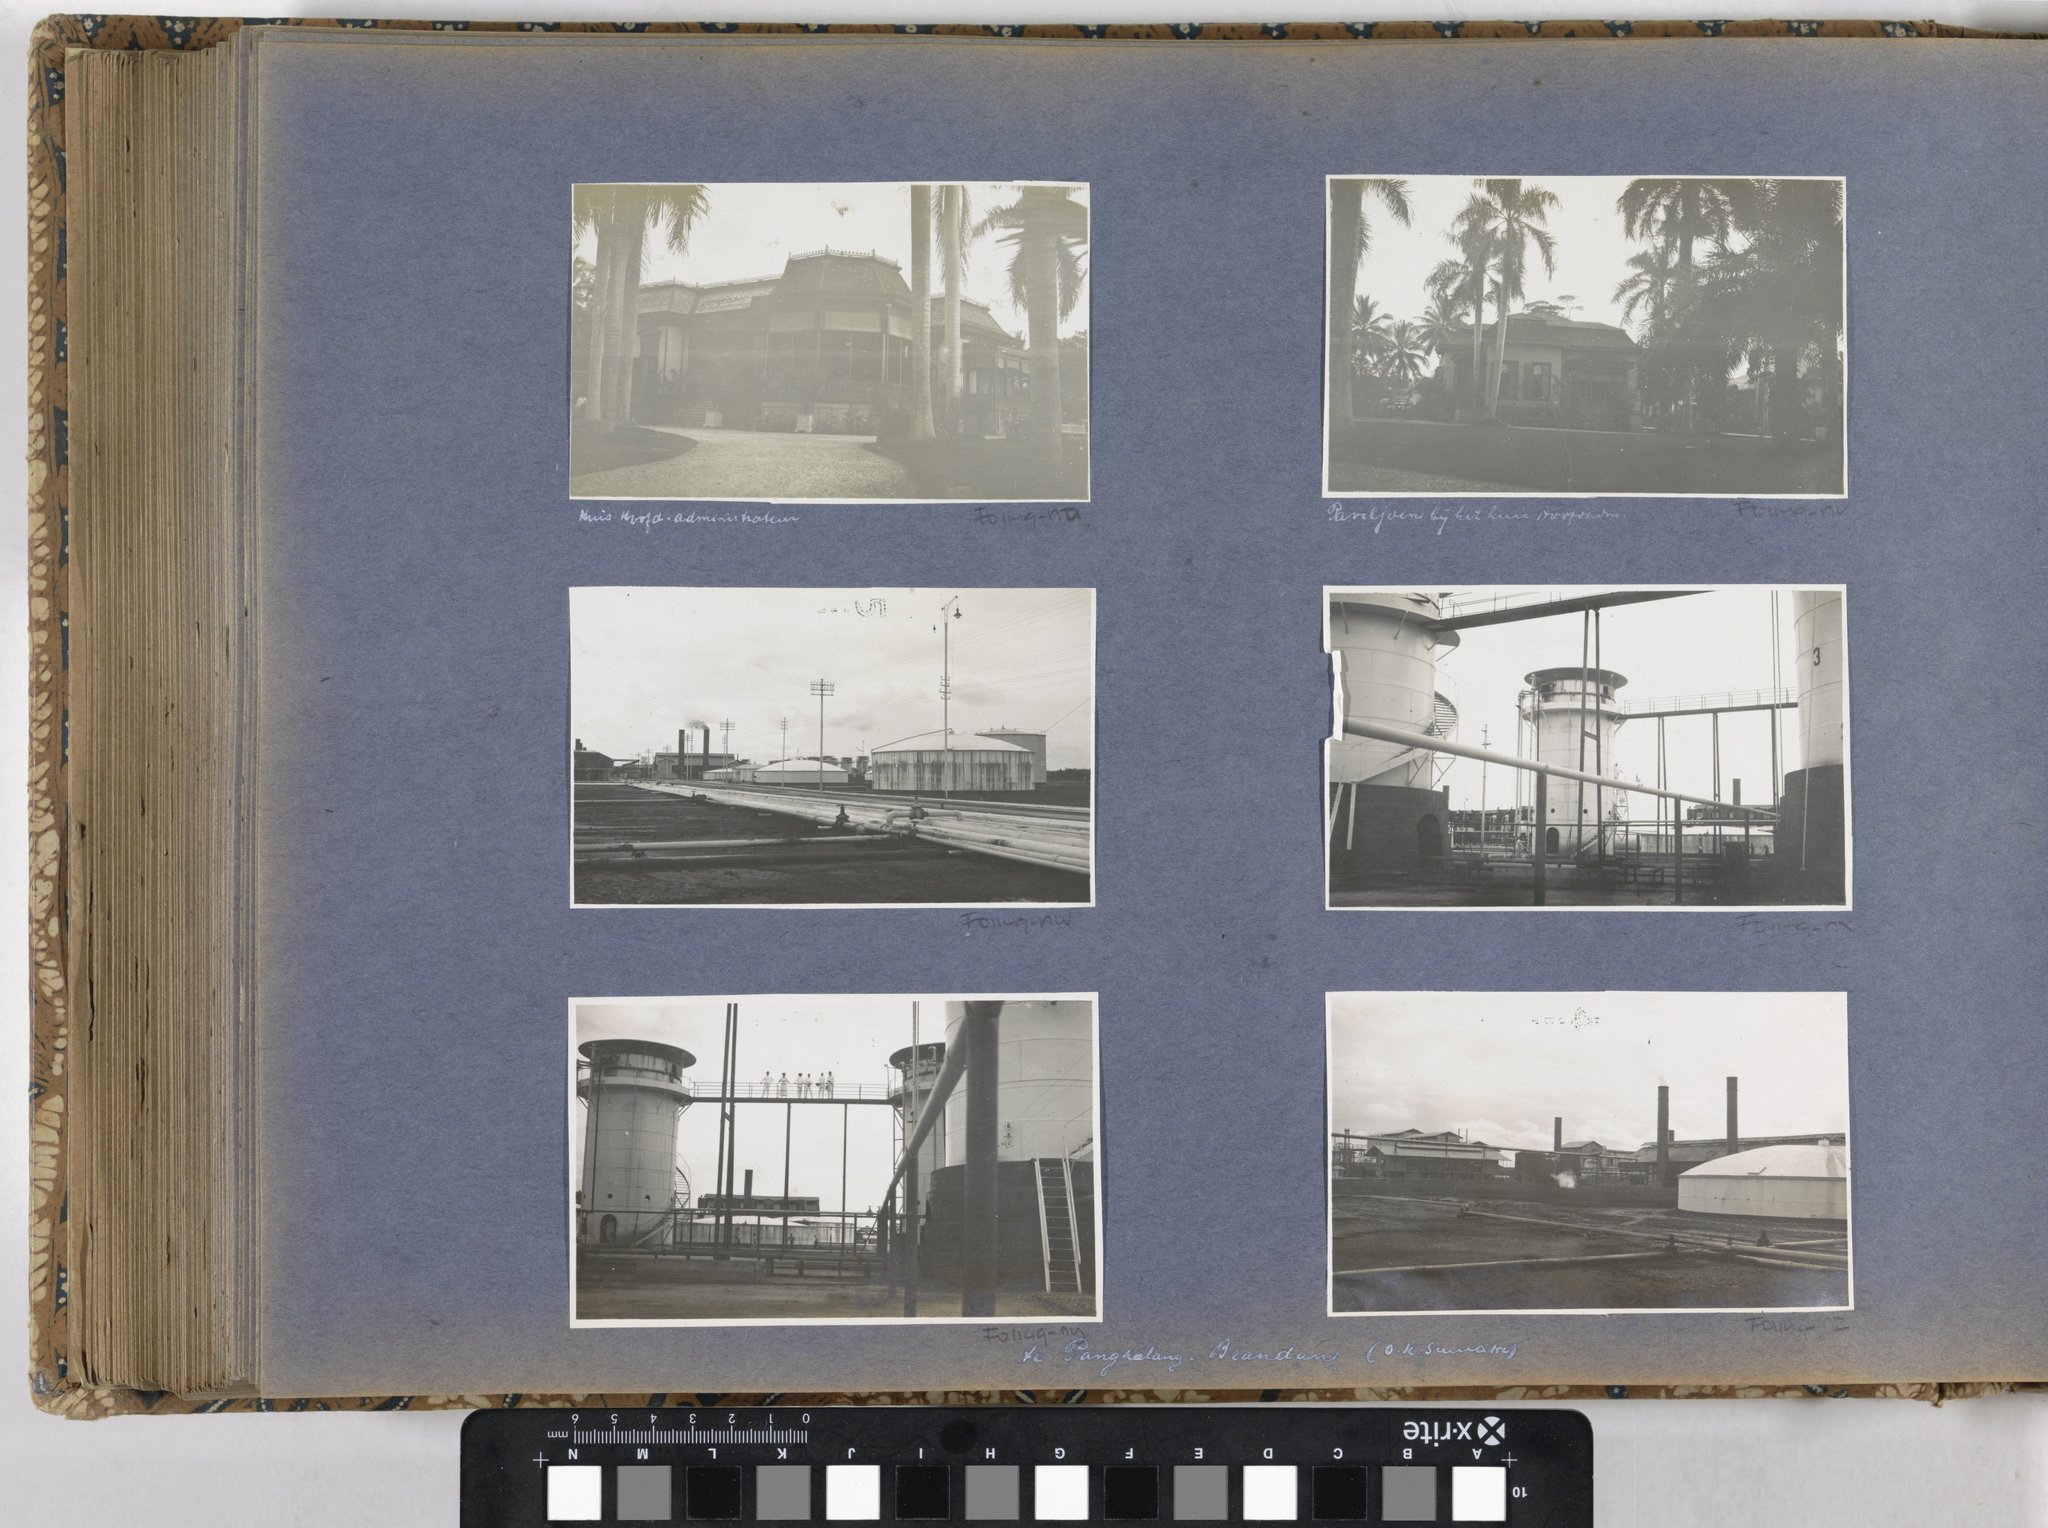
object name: album leaf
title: Paviljoen bij het huis van de hoofdadministrateur te Pangkalan-Brandan op Sumatra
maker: Anonymous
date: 1900-1920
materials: paper, photographic support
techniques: gelatin silver print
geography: sumatra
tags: oil; oil refinery, rural housing, e.g. country-house, villa, cottage, sumatra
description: Onderdeel van reisalbum met foto's van bedrijvigheid en bezienswaardigheden op Sumatra en Java en van de reis naar en van Nederlands-Indië.